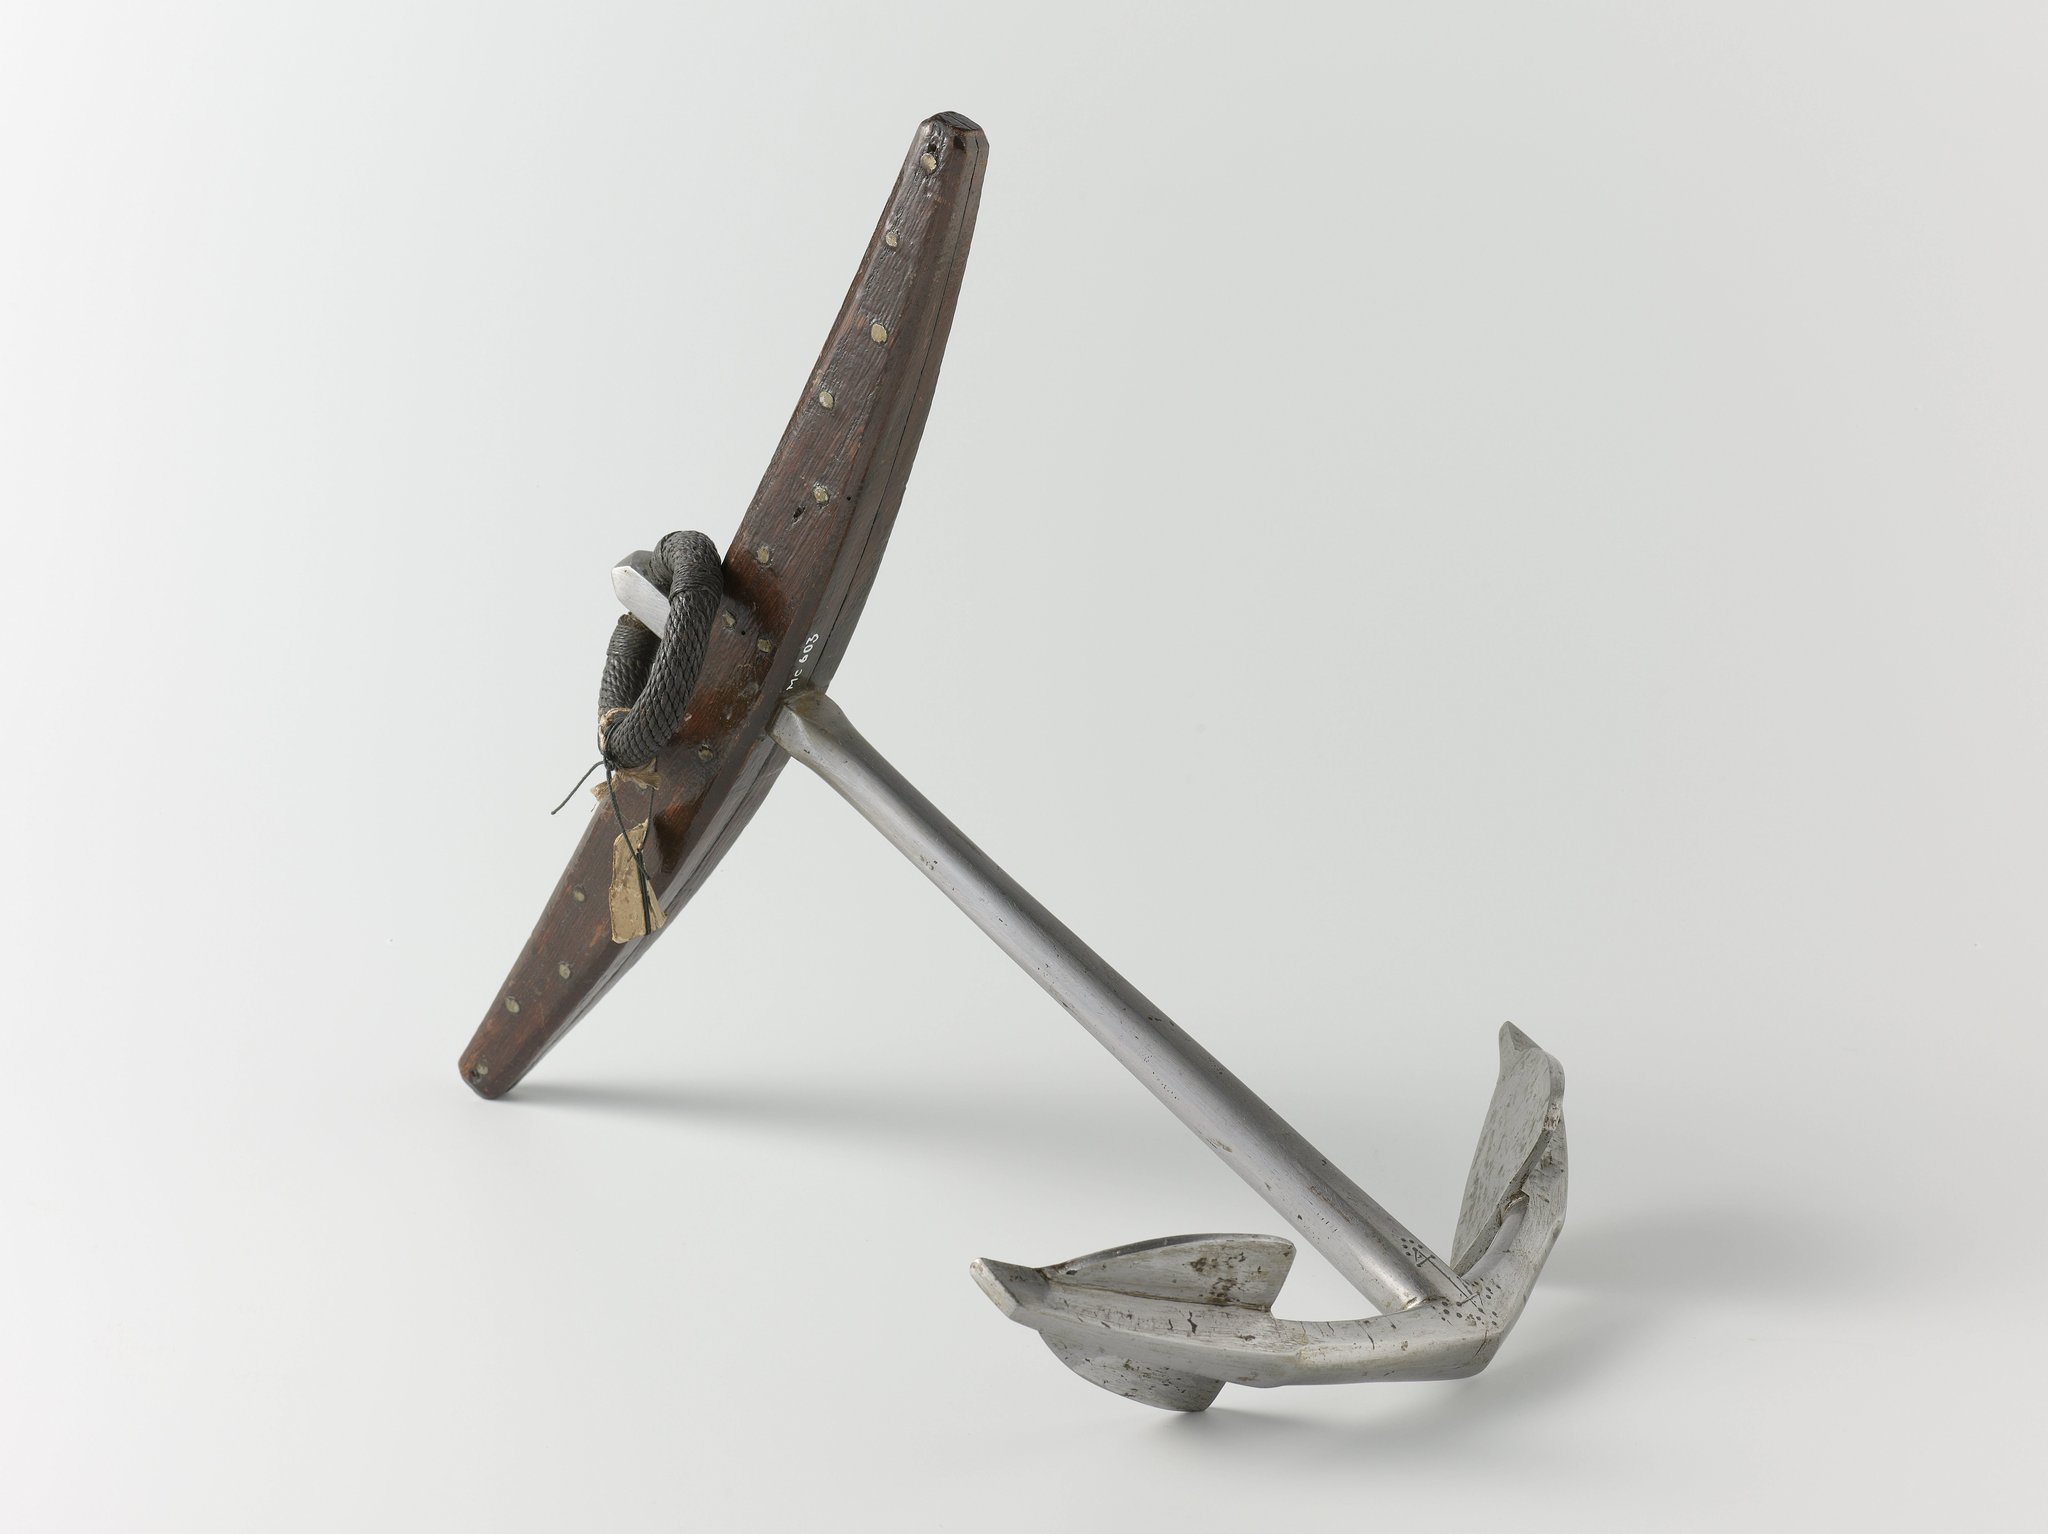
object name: instruction model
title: Model of an Anchor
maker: Anonymous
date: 1800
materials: brass, iron, fiber, wood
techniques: tarring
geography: netherlands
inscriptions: mark: linear property mark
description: Model van een gewoon anker, bestaande uit een schacht met een gebogen arm met ankerhanden op de uiteinden. Houten ankerstok; ijzeren ankerring met ankerroering van geteerd touw. Schaal 1:10 (schatting).